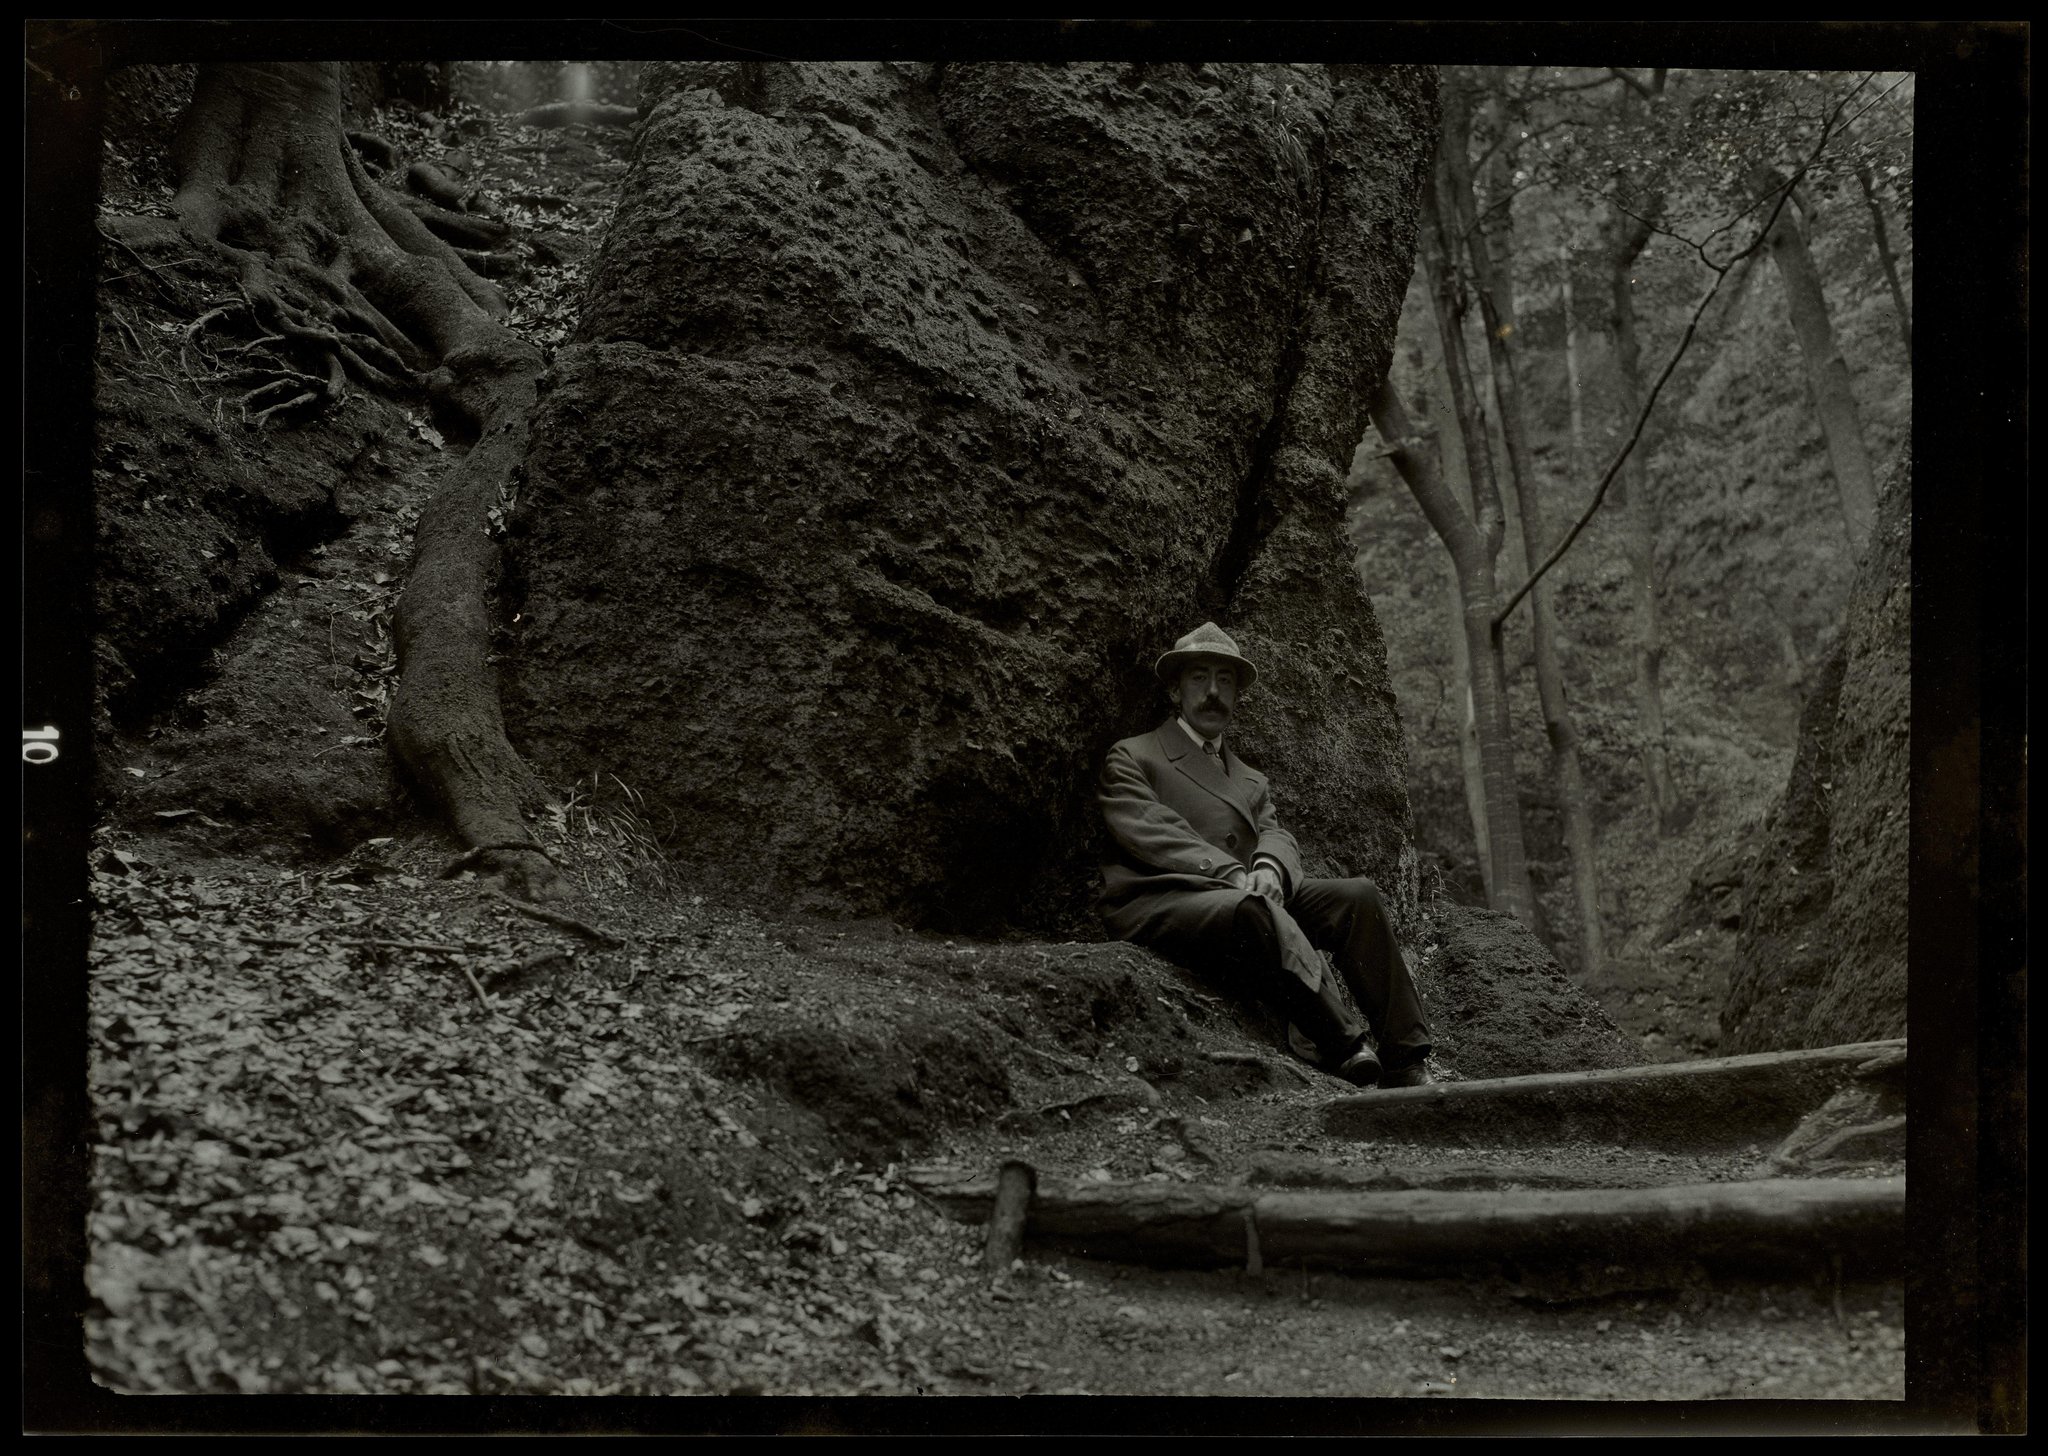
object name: negative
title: Filmnegatief met opname van Eisenach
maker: Anonymous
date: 1921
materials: film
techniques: gelatin silver negative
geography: germany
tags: eisenach